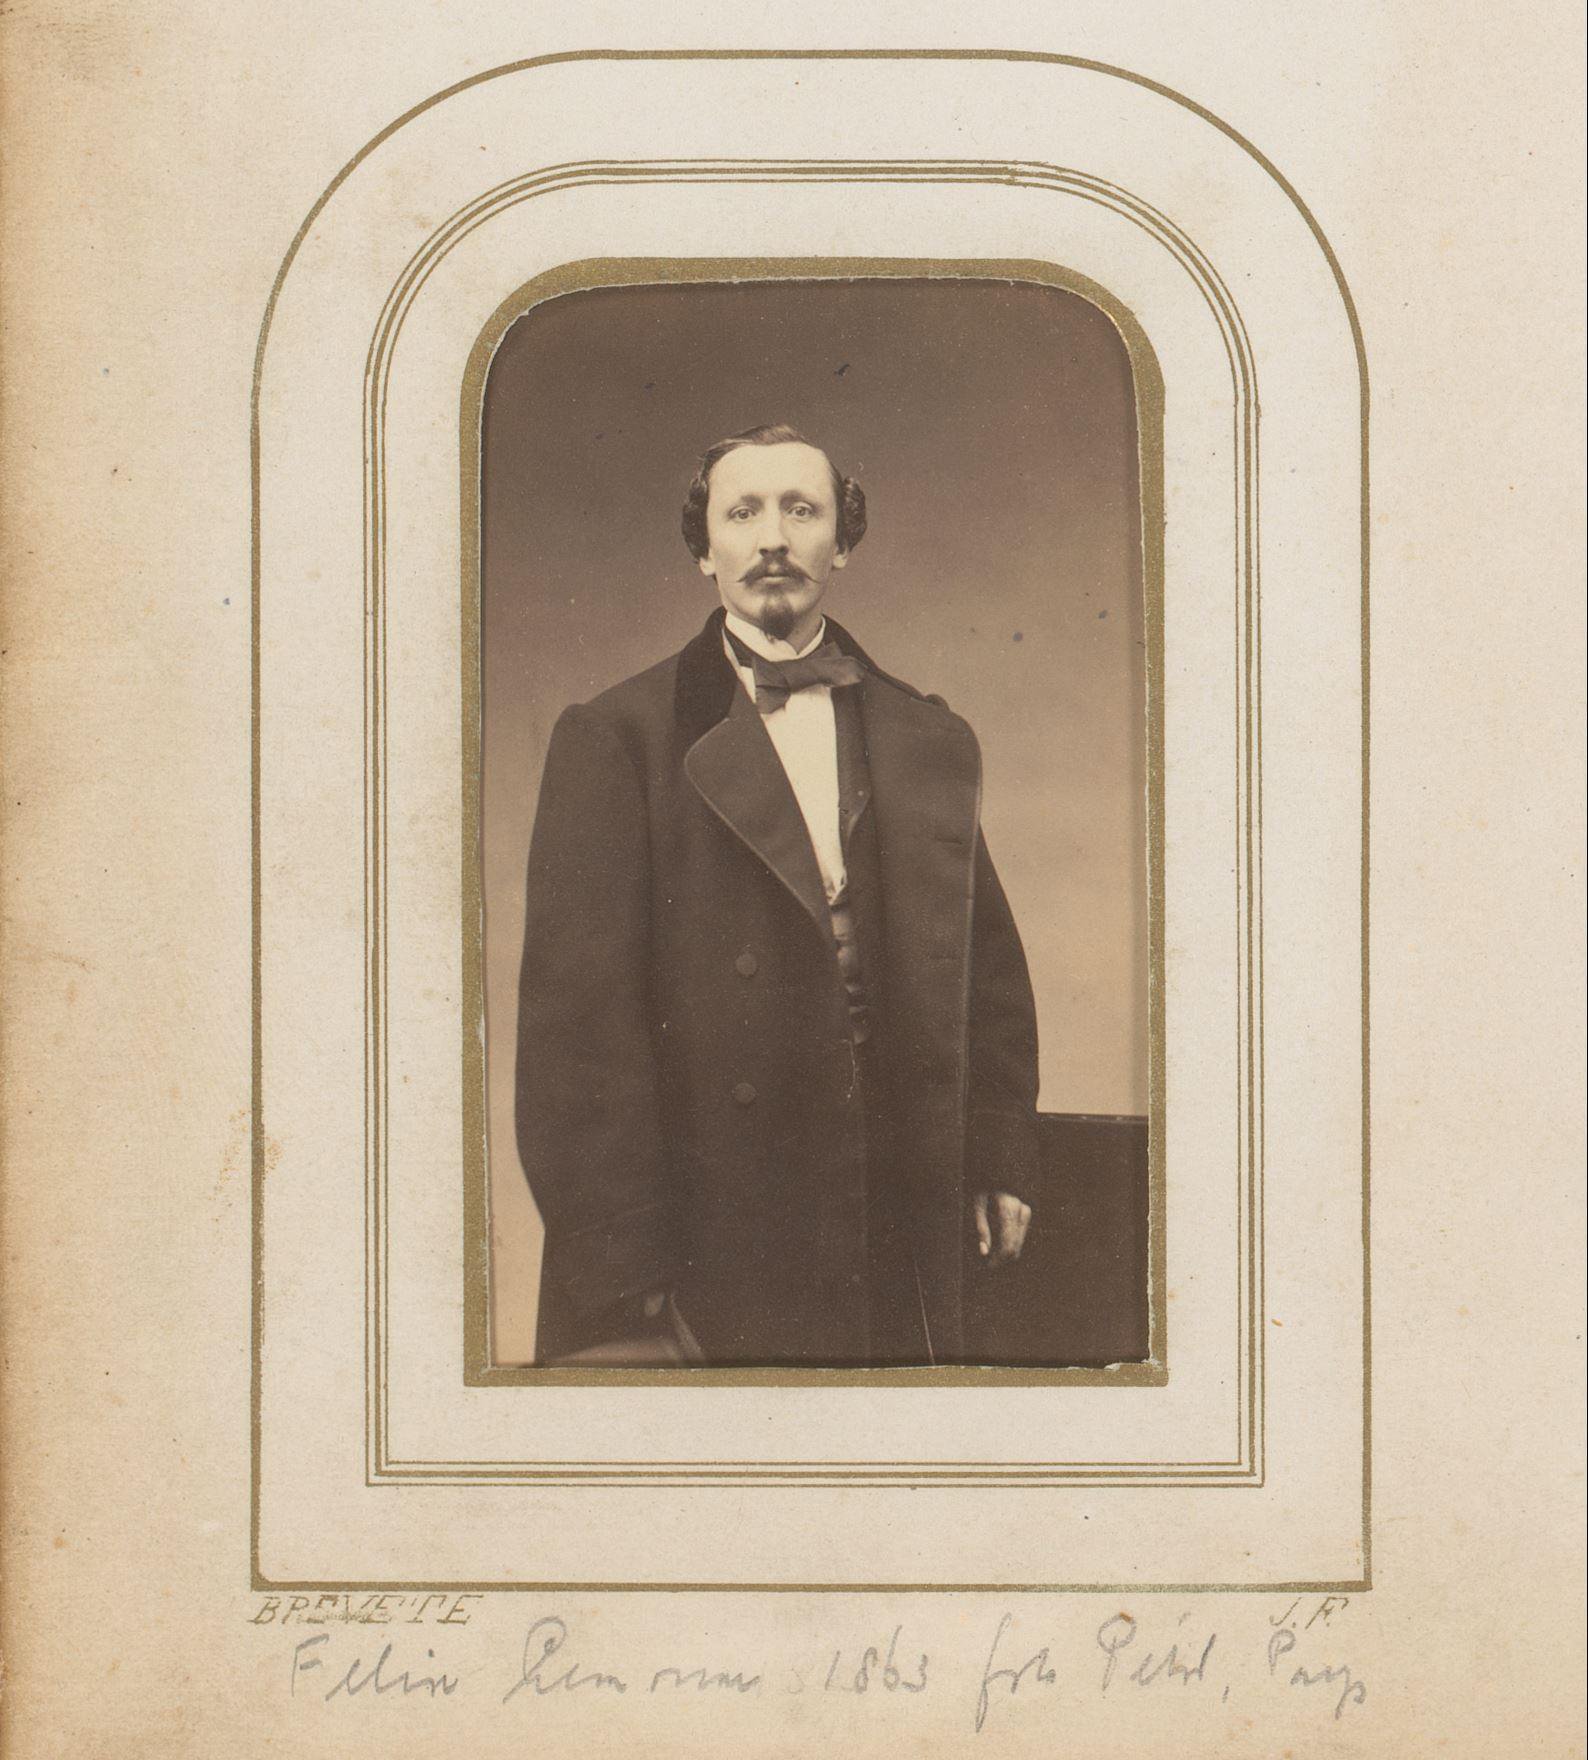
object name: photograph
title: Portret van een man, aangeduid als Felix Lemoine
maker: pierre petit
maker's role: fotograaf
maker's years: 1832-1909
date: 1863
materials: cardboard, photographic support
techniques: albumen print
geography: paris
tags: historical persons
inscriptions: inscription: ‘Paris Besançon/ Pierre Petit/ Photographe/ 31, Place Cadet/ Paris’, annotation: ‘A mon bon frère/ Alexandre/ Felix/ tous le 1er Janvier/ 1863’, annotation: ‘Felix Lemoine 1863 foto Petit Pierre’